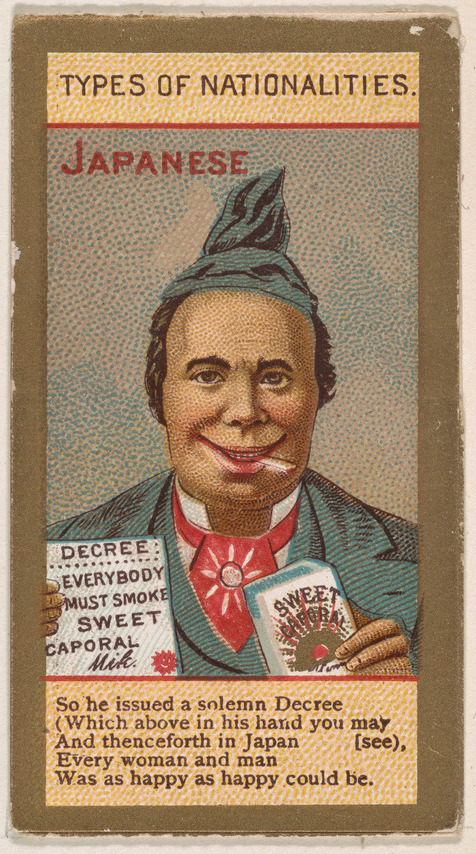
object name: print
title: Japanese, from Types of Nationalities (N240) issued by Kinney Bros.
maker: kinney brothers tobacco company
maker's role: publisher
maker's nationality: american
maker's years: 1869-2011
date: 1890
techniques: color lithograph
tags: men